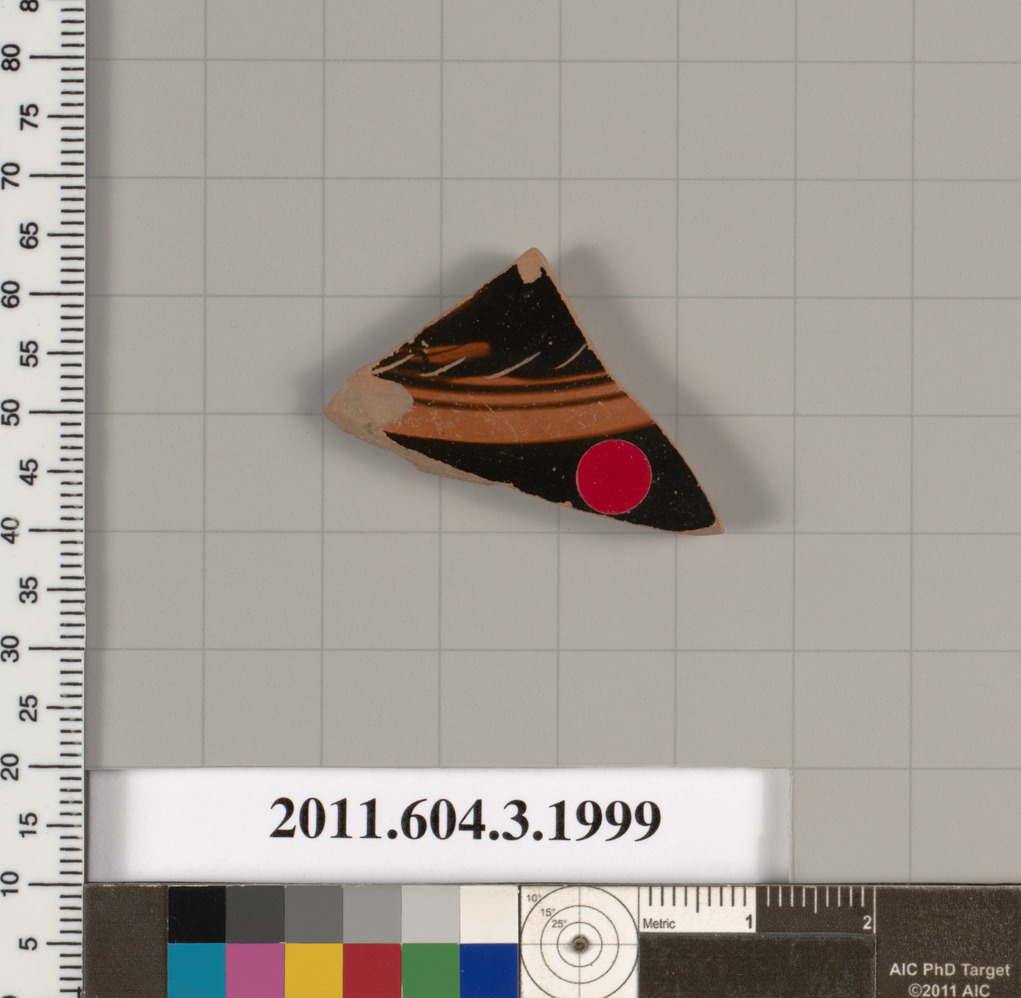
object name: kylix fragment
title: Terracotta fragment of a kylix (drinking cup)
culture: greek, attic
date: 550-526 BCE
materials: terracotta